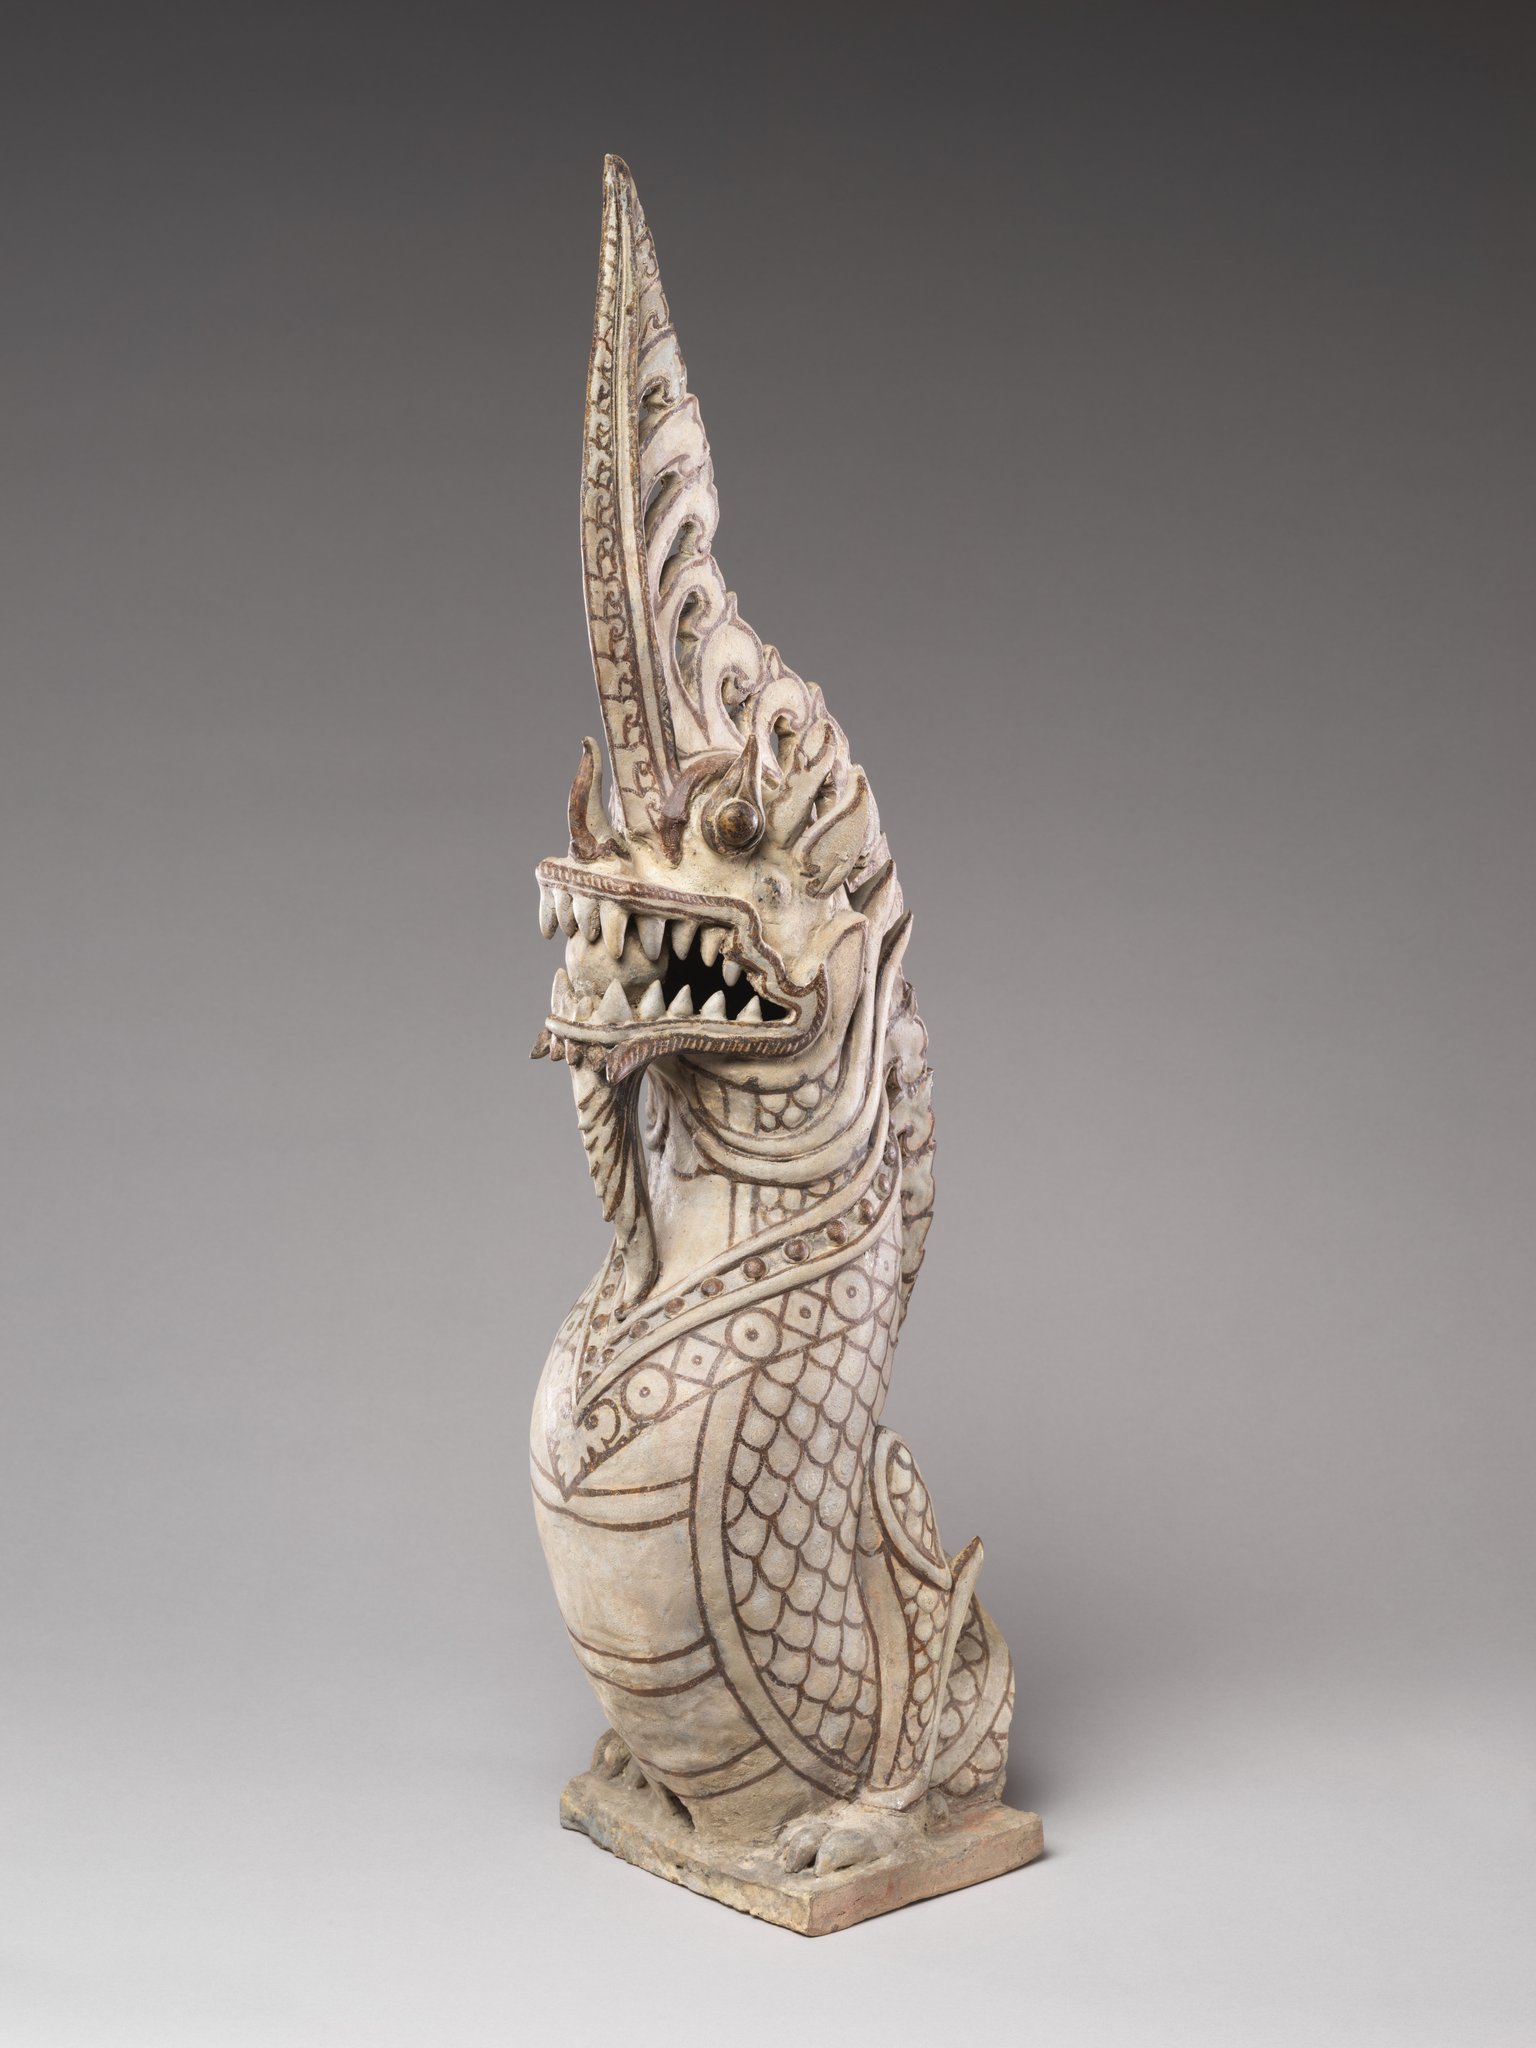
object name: finial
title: Architectural antefix in form of a makara finial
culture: north-central thai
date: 1367-1500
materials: iron, stoneware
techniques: underglaze